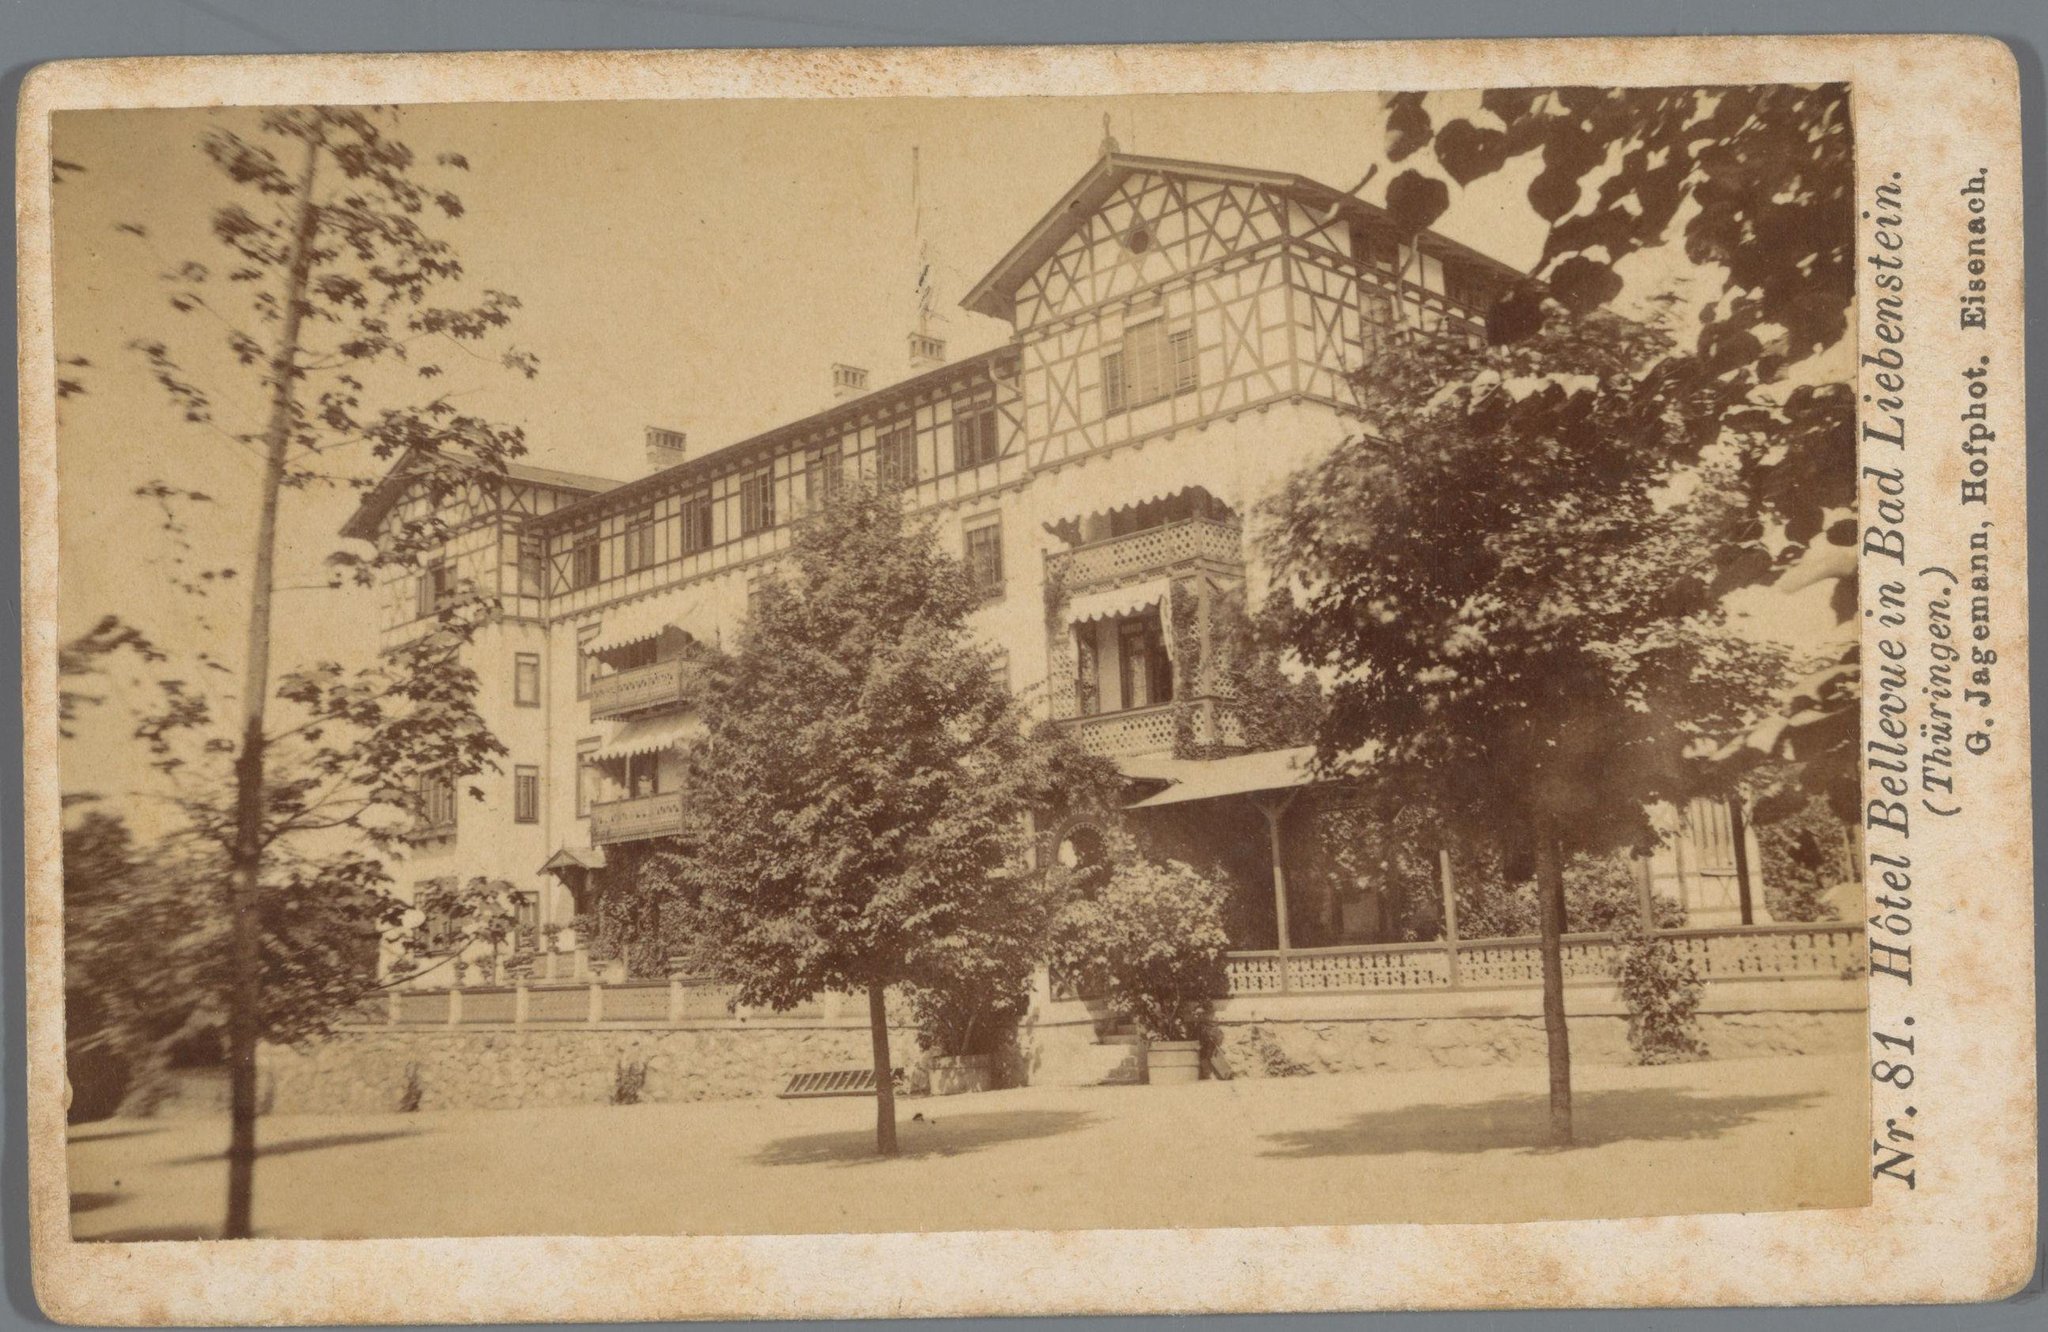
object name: carte de visite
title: Hôtel Bellevue in Bad Liebenstein (Thüringen)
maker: georg jagemann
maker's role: publisher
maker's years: 1817-1894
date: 1887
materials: cardboard, paper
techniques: albumen print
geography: bad liebenstein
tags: exterior ~ representation of a building, hotel, hostelry, inn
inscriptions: number: ‘Nr. 81.’, inscription: ‘G. Jagemann, Hofphot. Eisenach.’